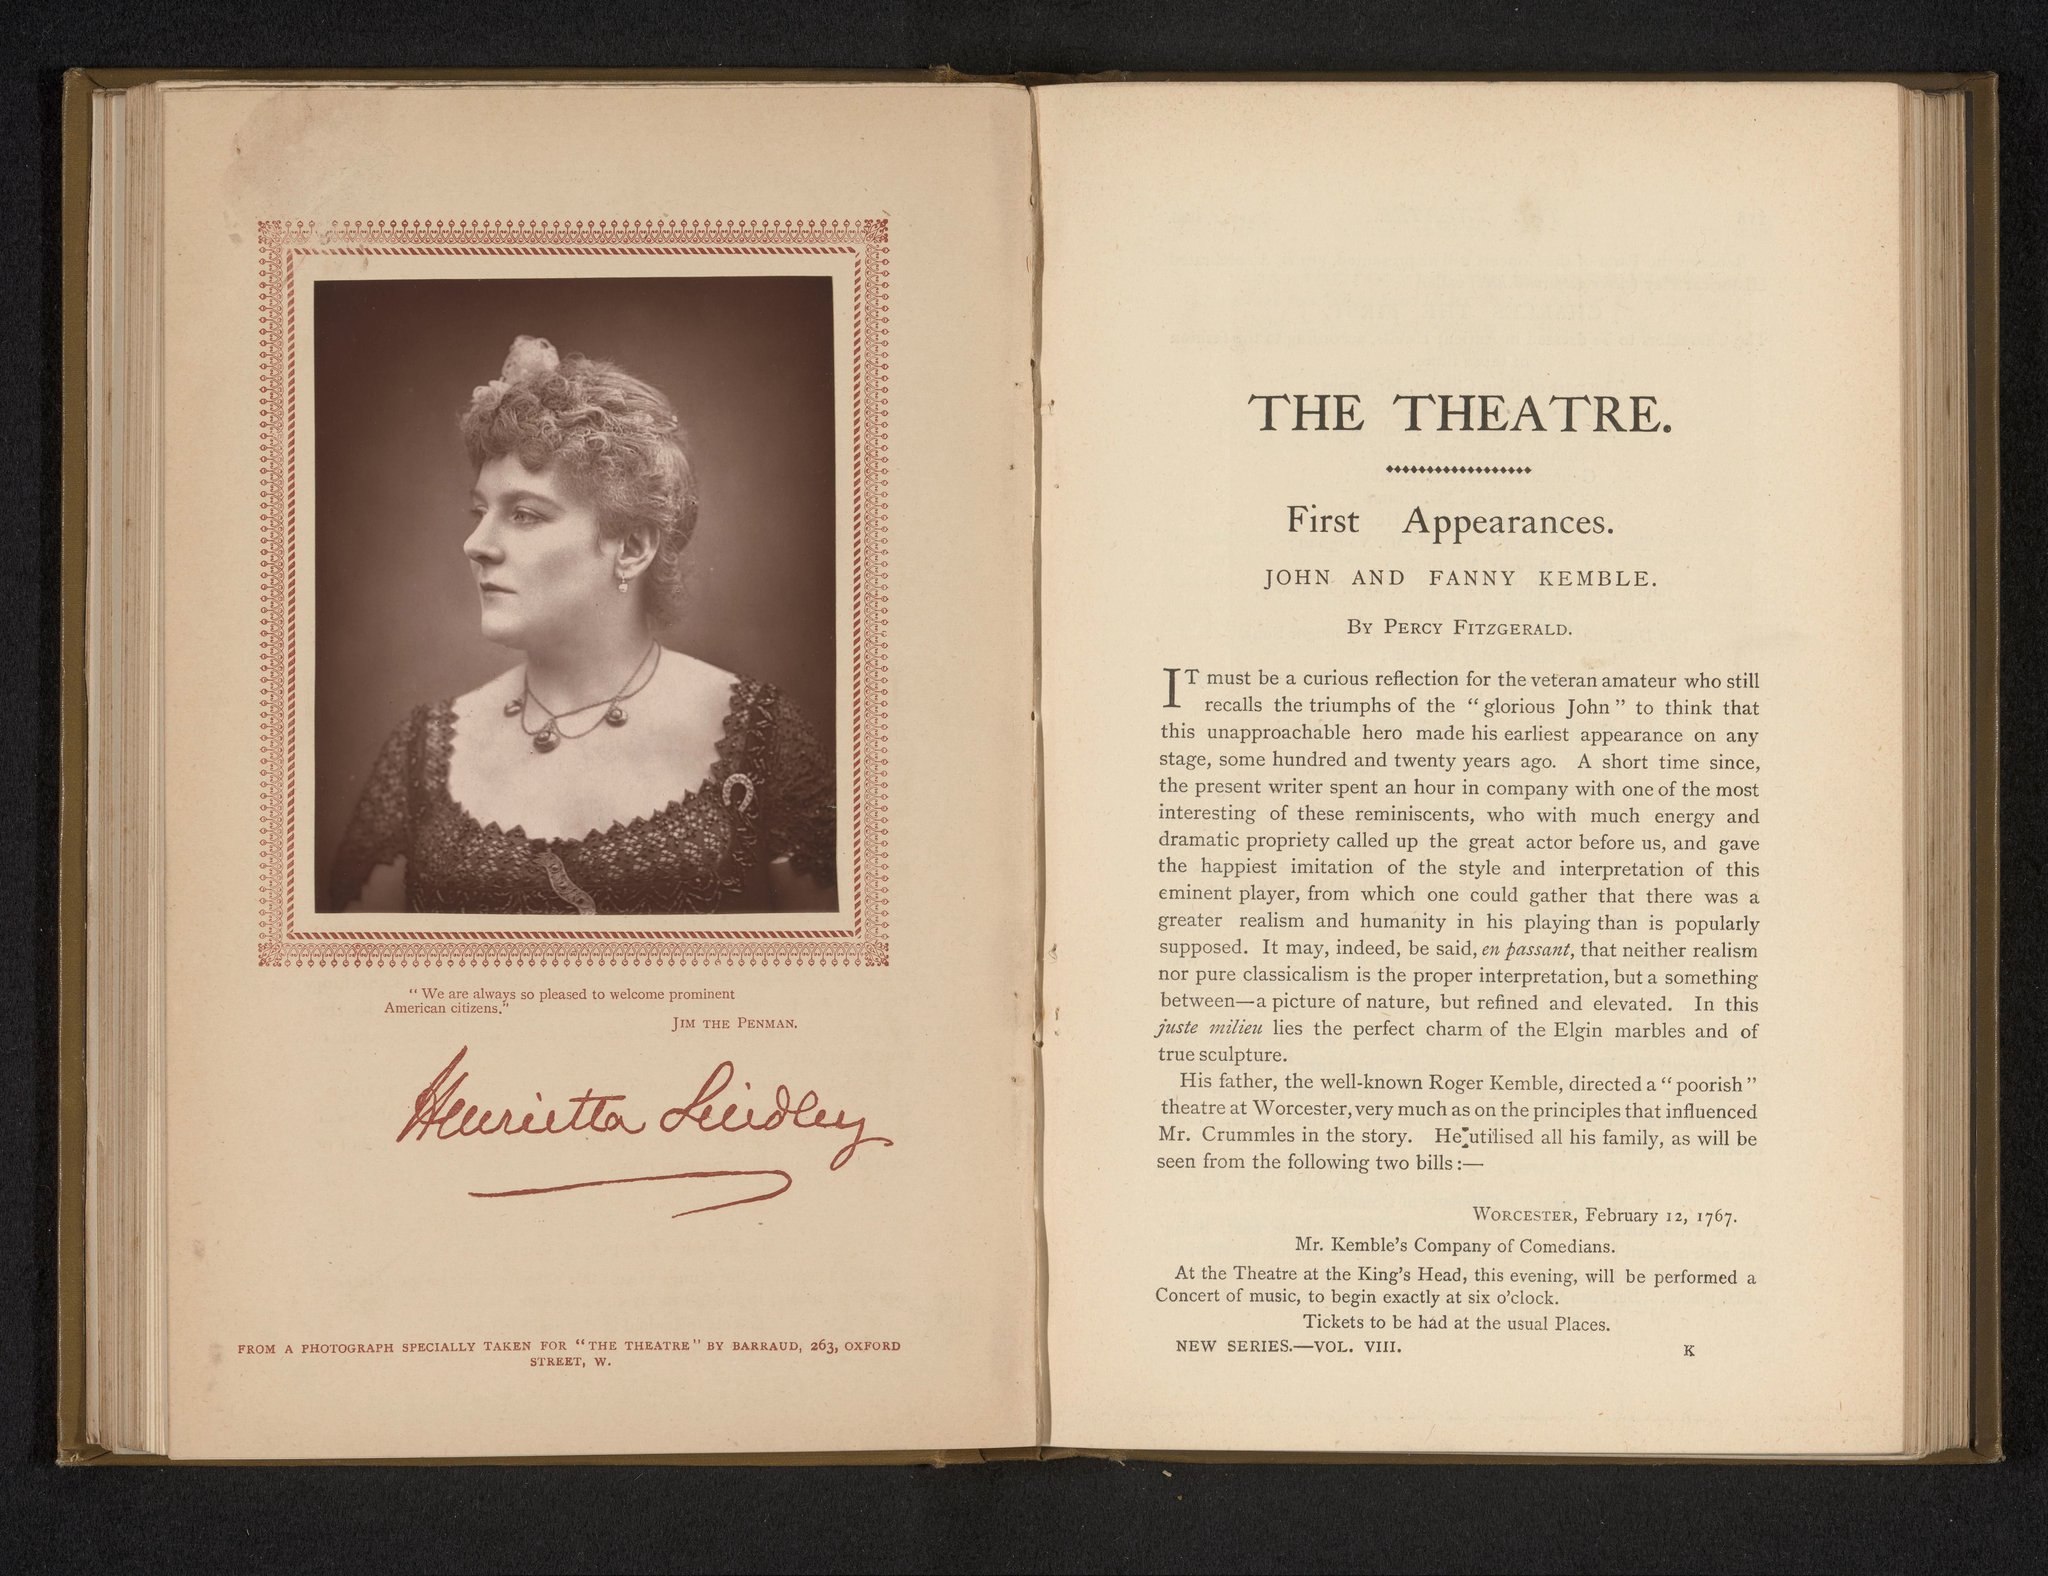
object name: page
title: Portret van Henrietta Lindley in 'Jim the Penman'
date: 1881-1886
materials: paper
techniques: woodburytype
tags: adult woman, historical persons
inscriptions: signature: ‘Henrietta Lindley’, inscription: ‘'We are always so pleased to welcome prominent/ American citizens.'/ Jim the Penman’